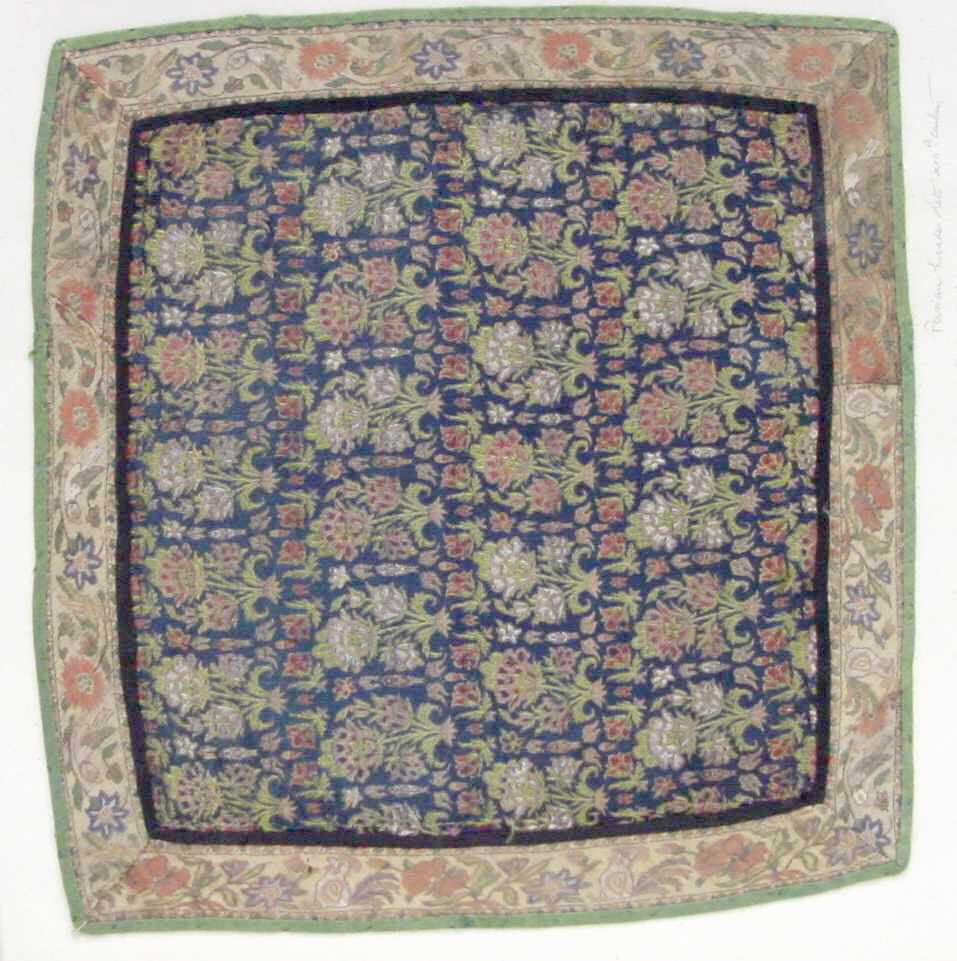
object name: textile fragment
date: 1667-1700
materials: silk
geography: iran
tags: flowers